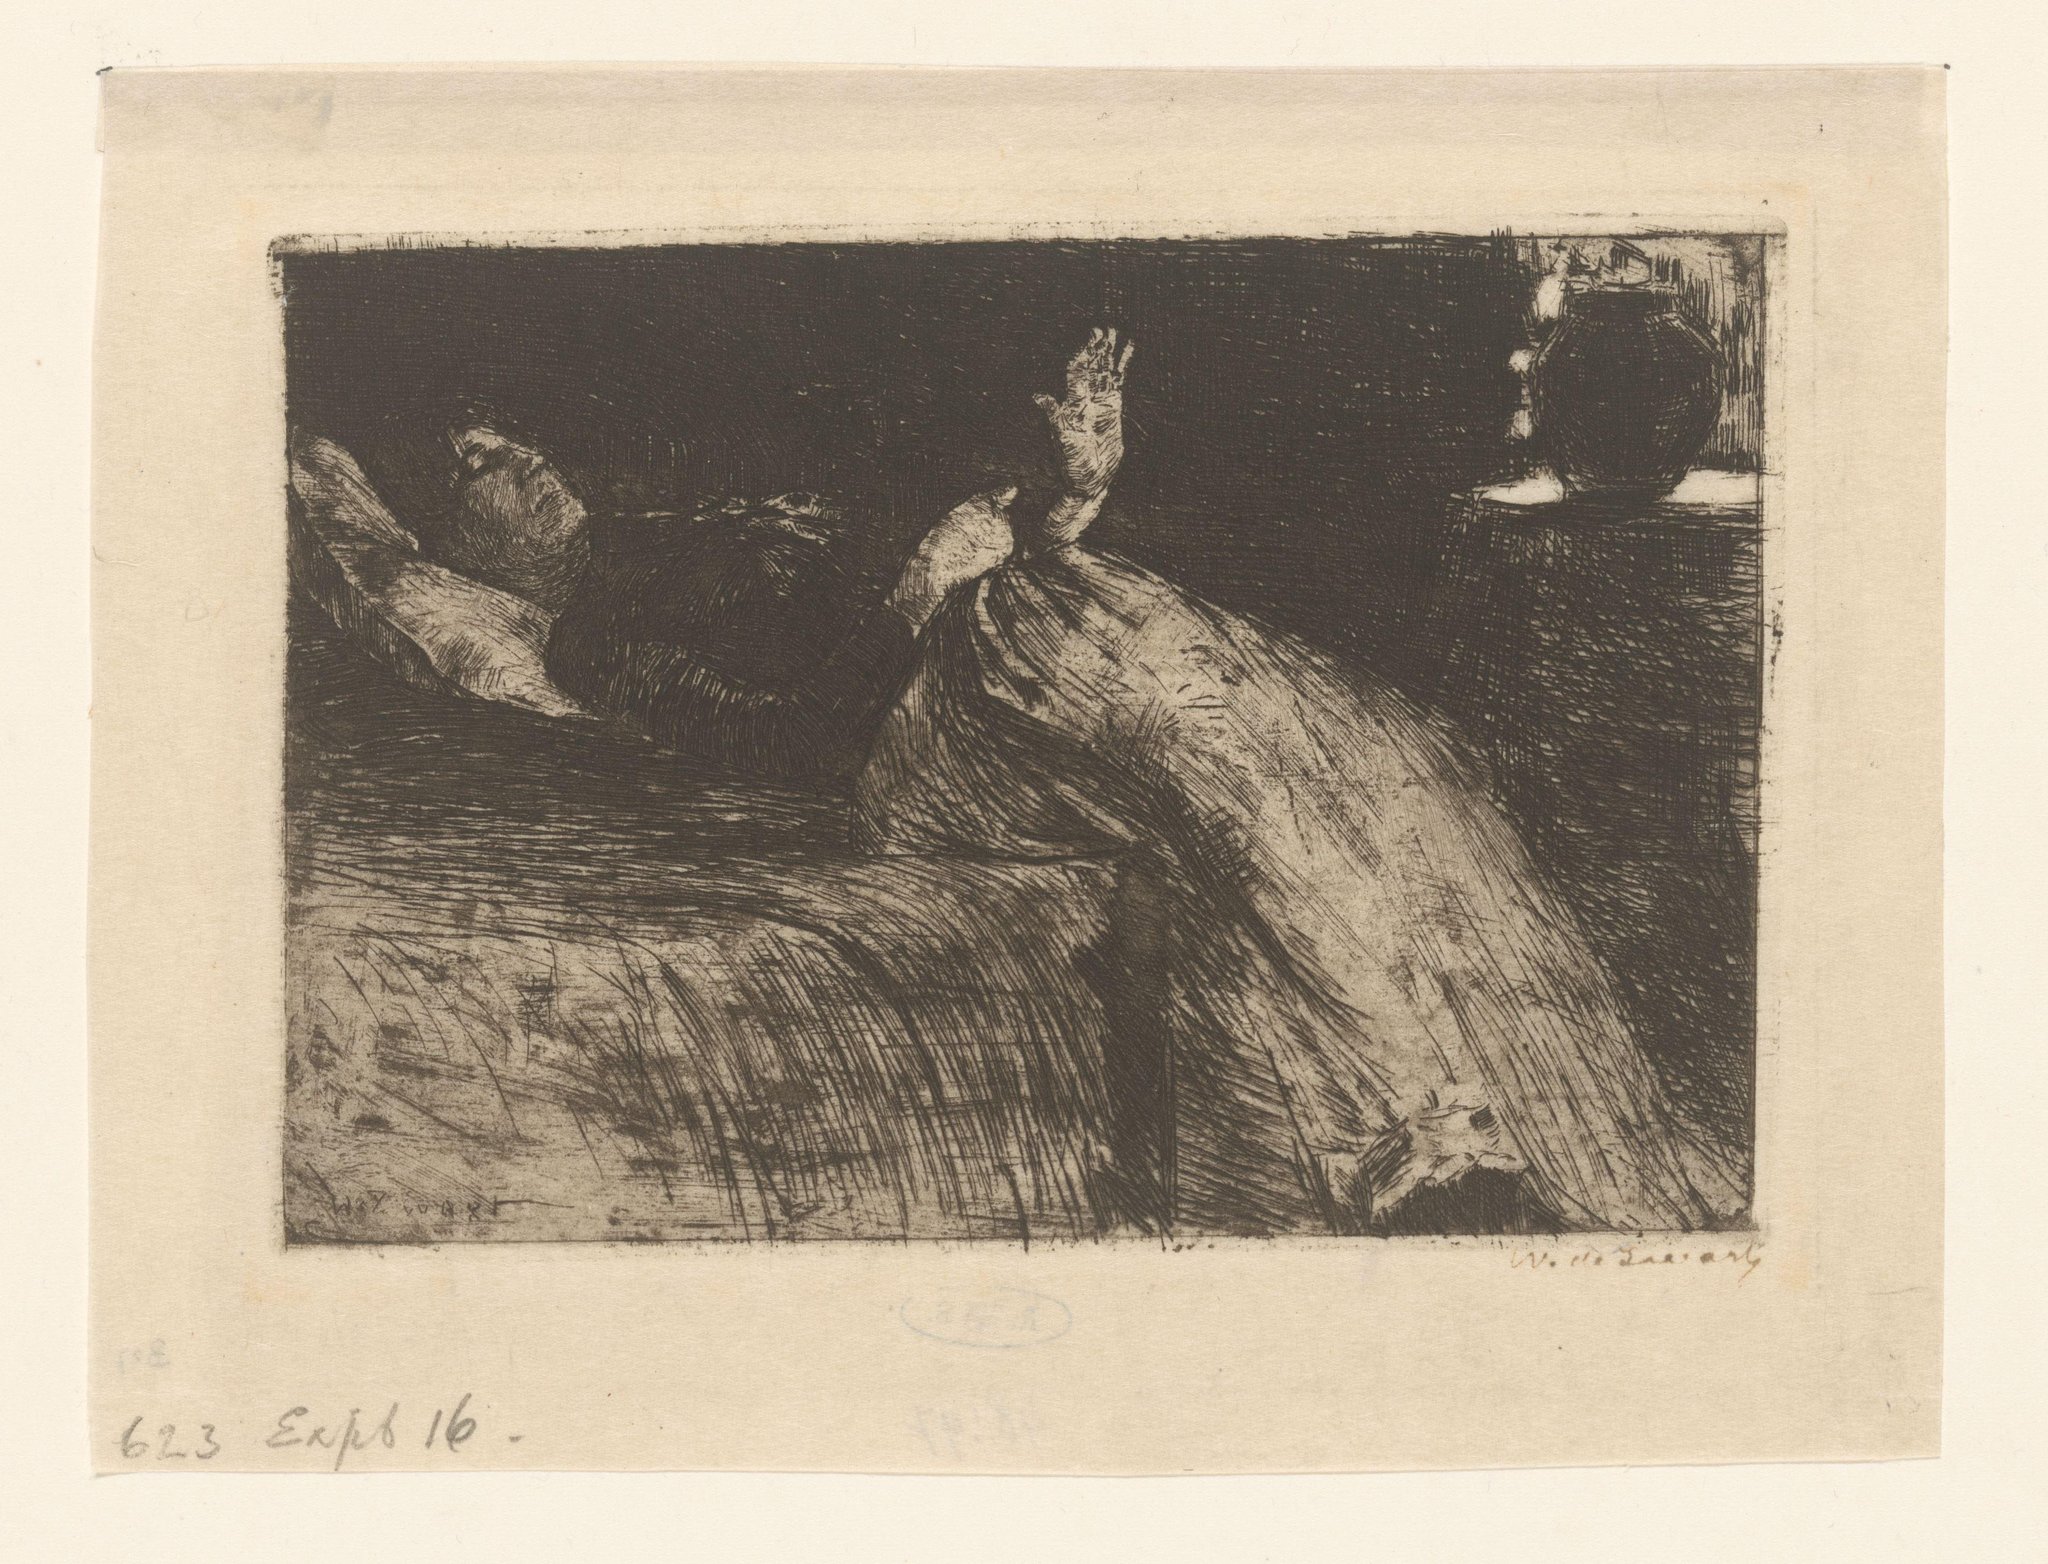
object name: print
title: Liggende vrouw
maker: willem de zwart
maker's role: draughtsman, painter, print maker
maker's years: 1862-1931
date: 1886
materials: paper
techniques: drypoint, etching, intaglio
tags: adult woman (+ lying)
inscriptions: collector's mark: Lugt 2228